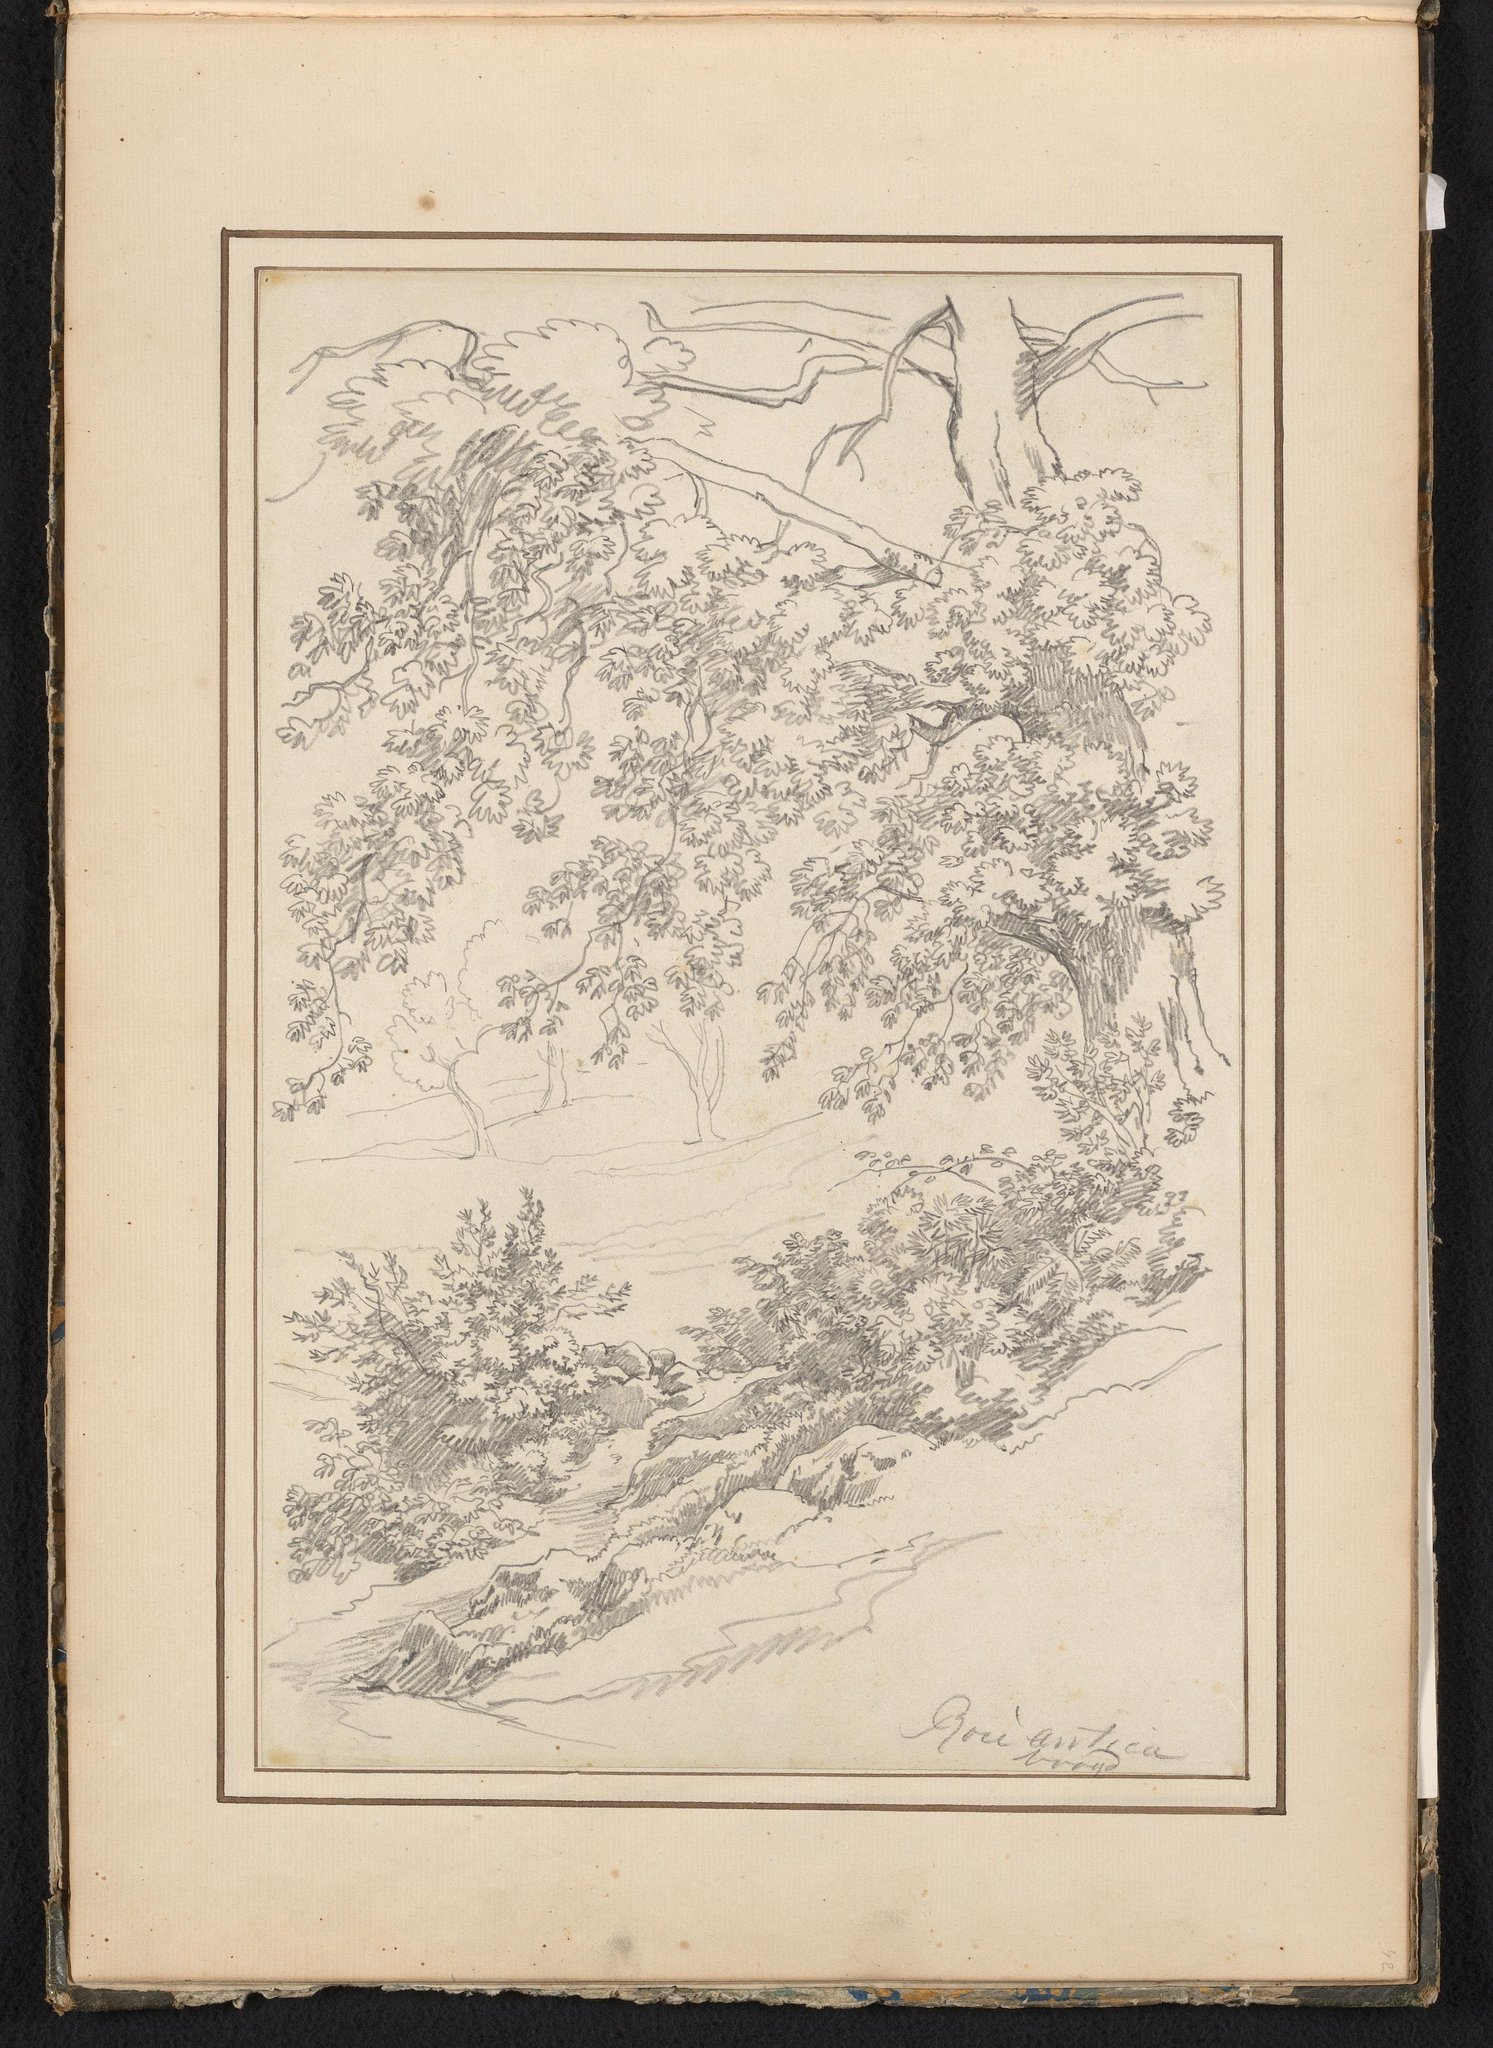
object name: album leaf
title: Landschap met bomen te Roccantica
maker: hendrik voogd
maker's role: draughtsman, painter, print maker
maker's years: 1768-1839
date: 1788-1839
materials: paper, pencil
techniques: pasting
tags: trees, landscapes, roccantica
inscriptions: inscription: ‘Rocc'antica’